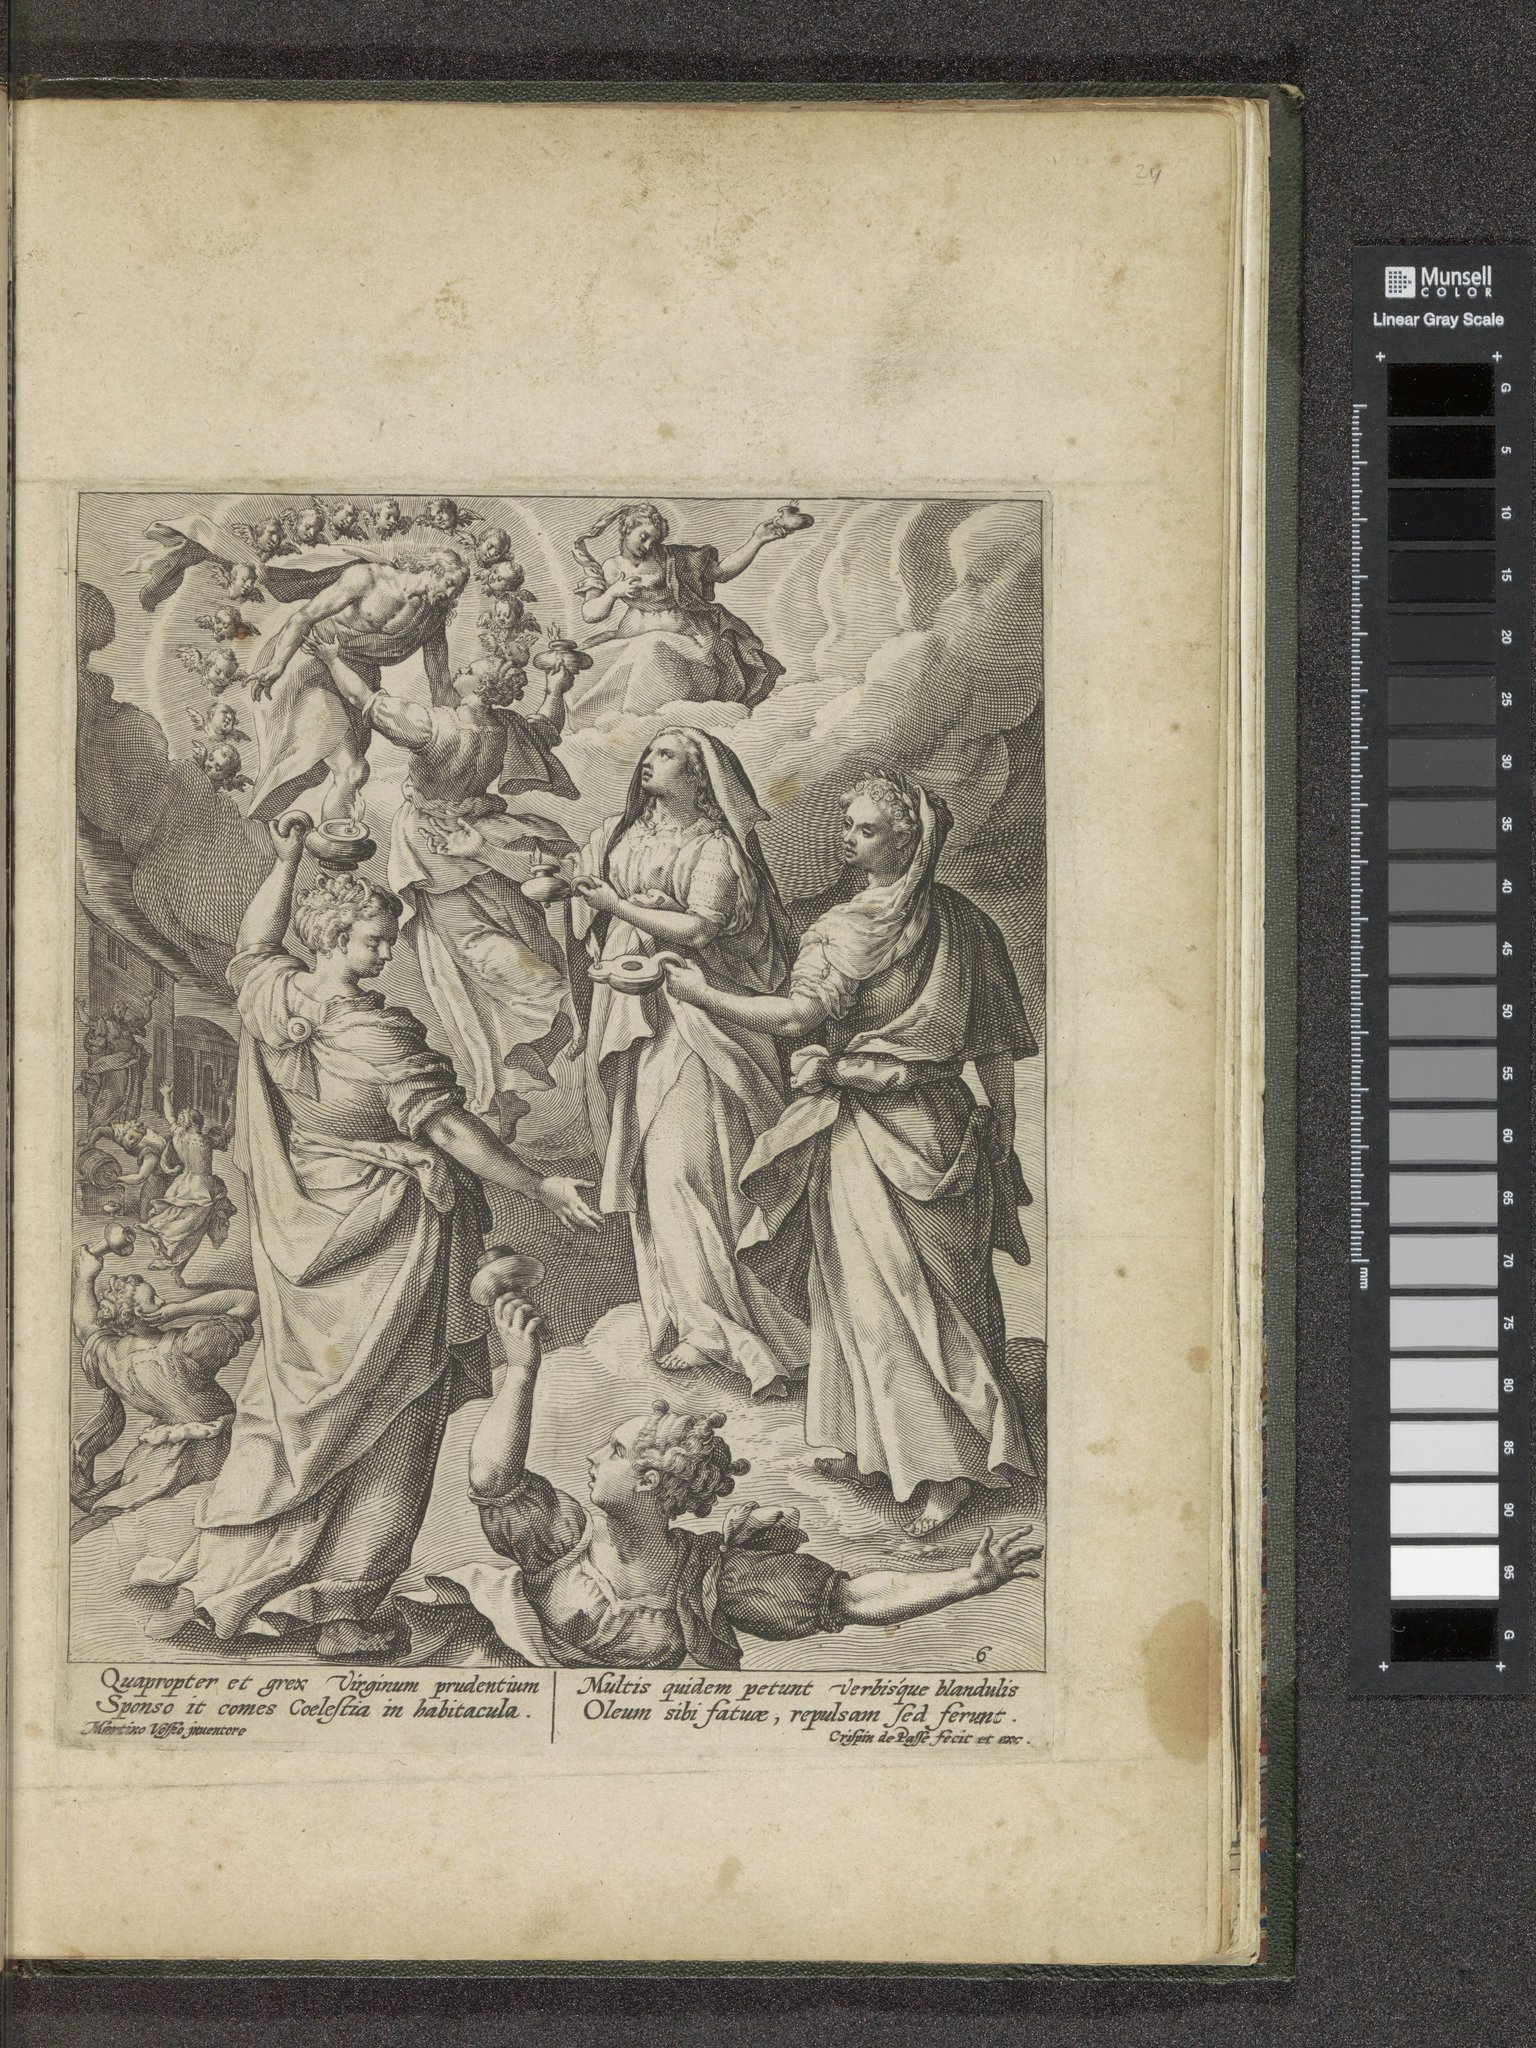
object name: album leaf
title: Gelijkenis van de vijf wijze en de vijf dwaze maagden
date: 1589-1611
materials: paper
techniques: engraving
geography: cologne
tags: the wise virgins are let into the house with the bridegroom (christ); the foolish virgins are shut out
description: De bruidegom (Christus) ontvangt de vijf wijze maagden die klaarstaan voor het bruiloftsfeest. Op de achtergrond zijn de dwaze maagden op zoek naar olie om hun lampen bij te vullen. In de marge een vierregelig onderschrift, in twee kolommen, in het Latijn dat verwijst naar de wijze maagden die in de hemel worden ontvangen en naar de dwaze maagden die buitengesloten worden. Deze prent maakt deel uit van een album.